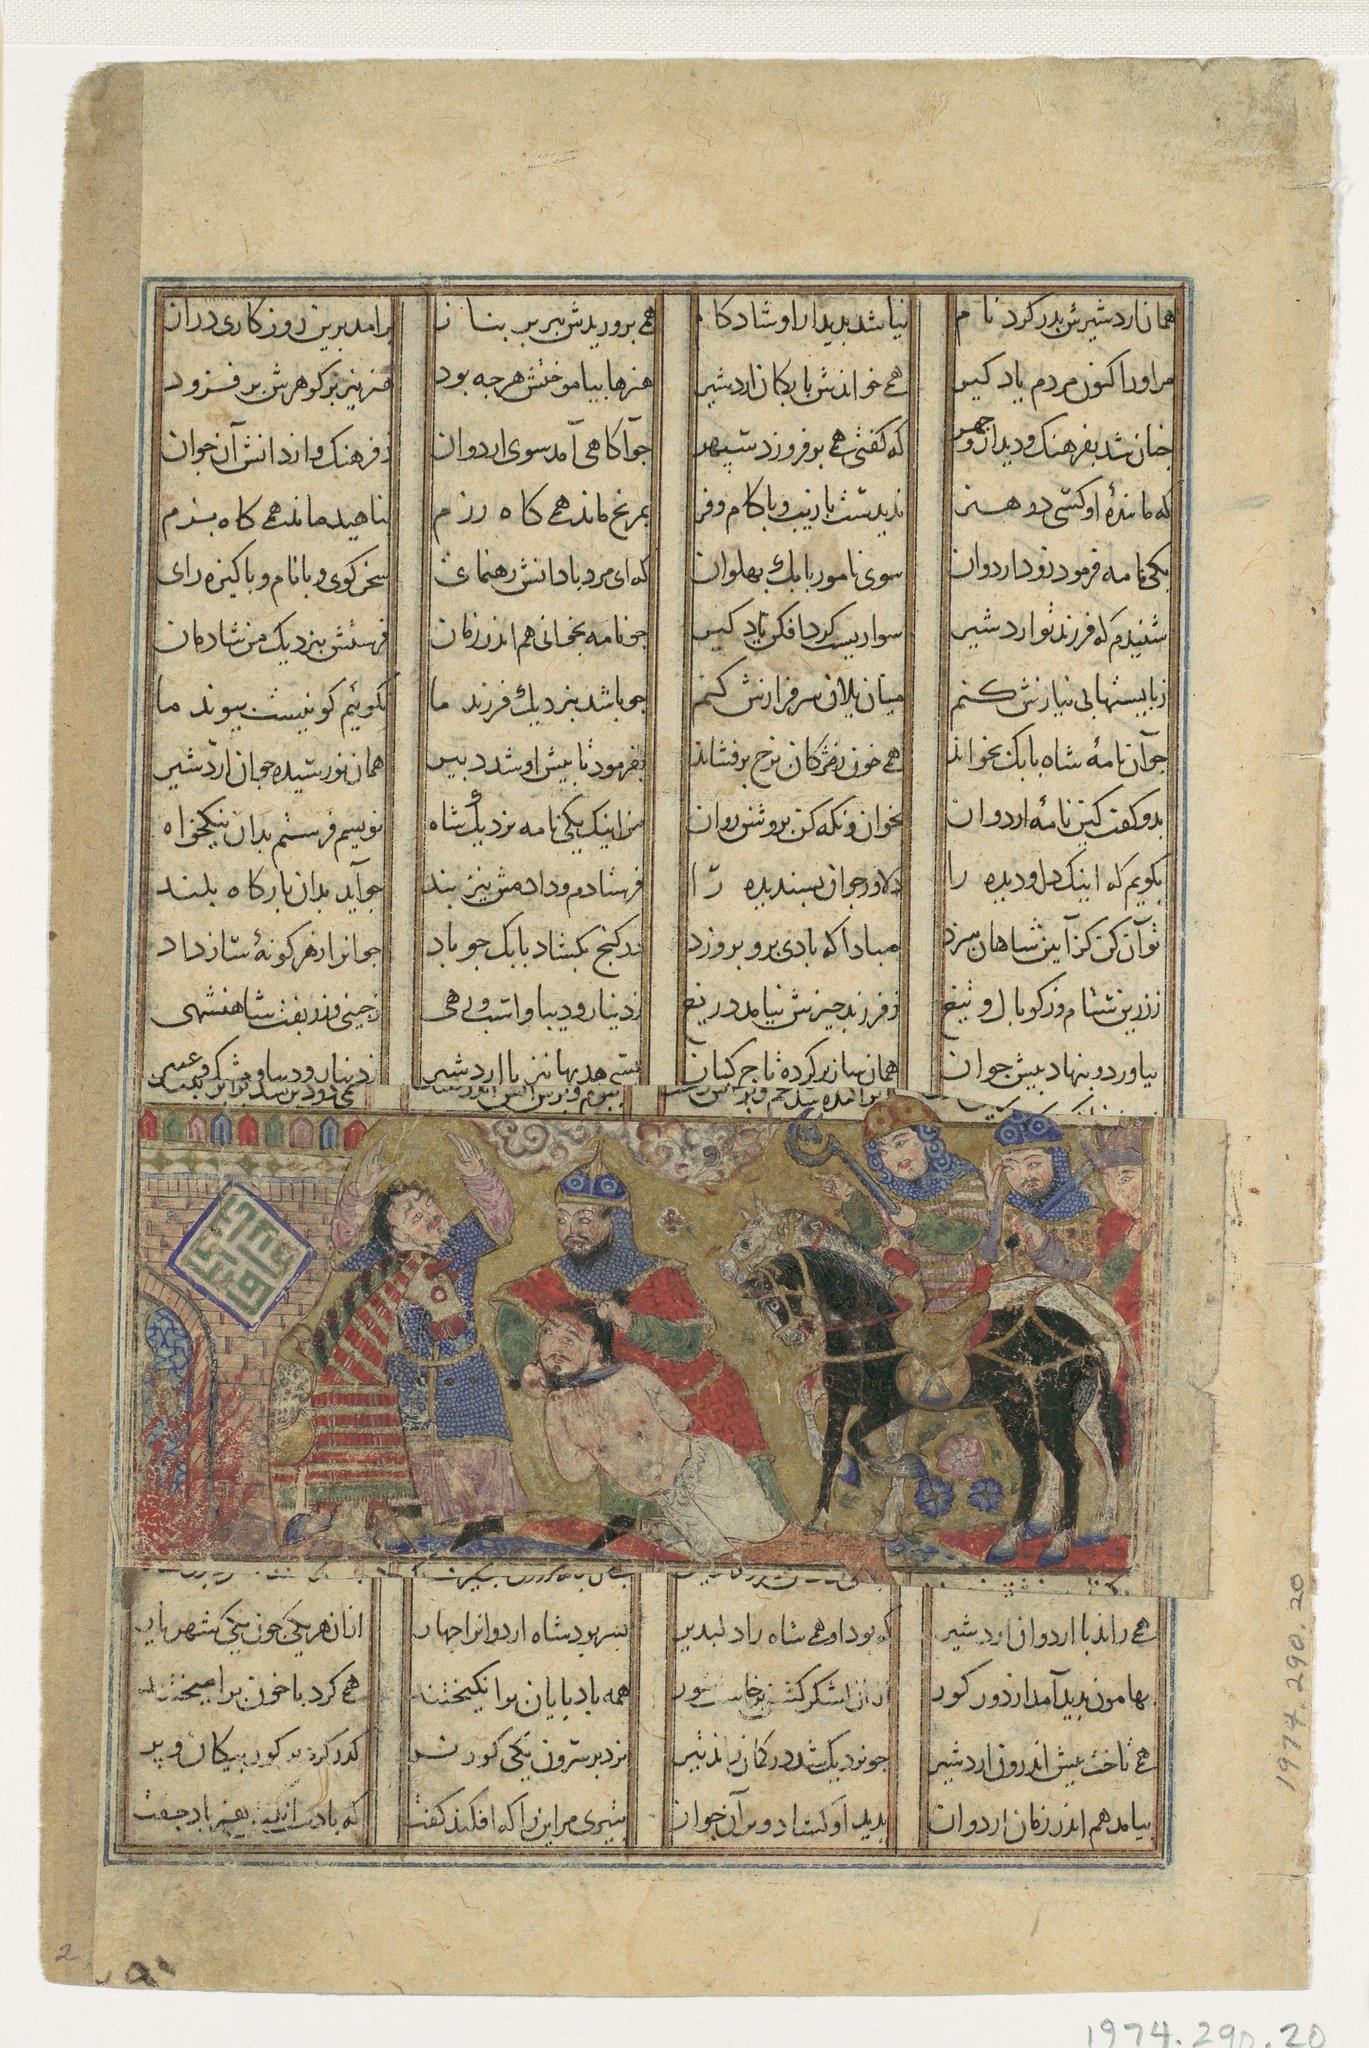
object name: folio from an illustrated manuscript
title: "Faramarz Slays Varazad", Folio from a Shahnama (Book of Kings) of Abu'l Qasim Firdausi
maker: abu'l qasim firdausi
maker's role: author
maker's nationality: iranian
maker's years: 935-1020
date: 1330-1340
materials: gold, ink, paper, silver, watercolor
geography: iran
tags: poetry,men,horses